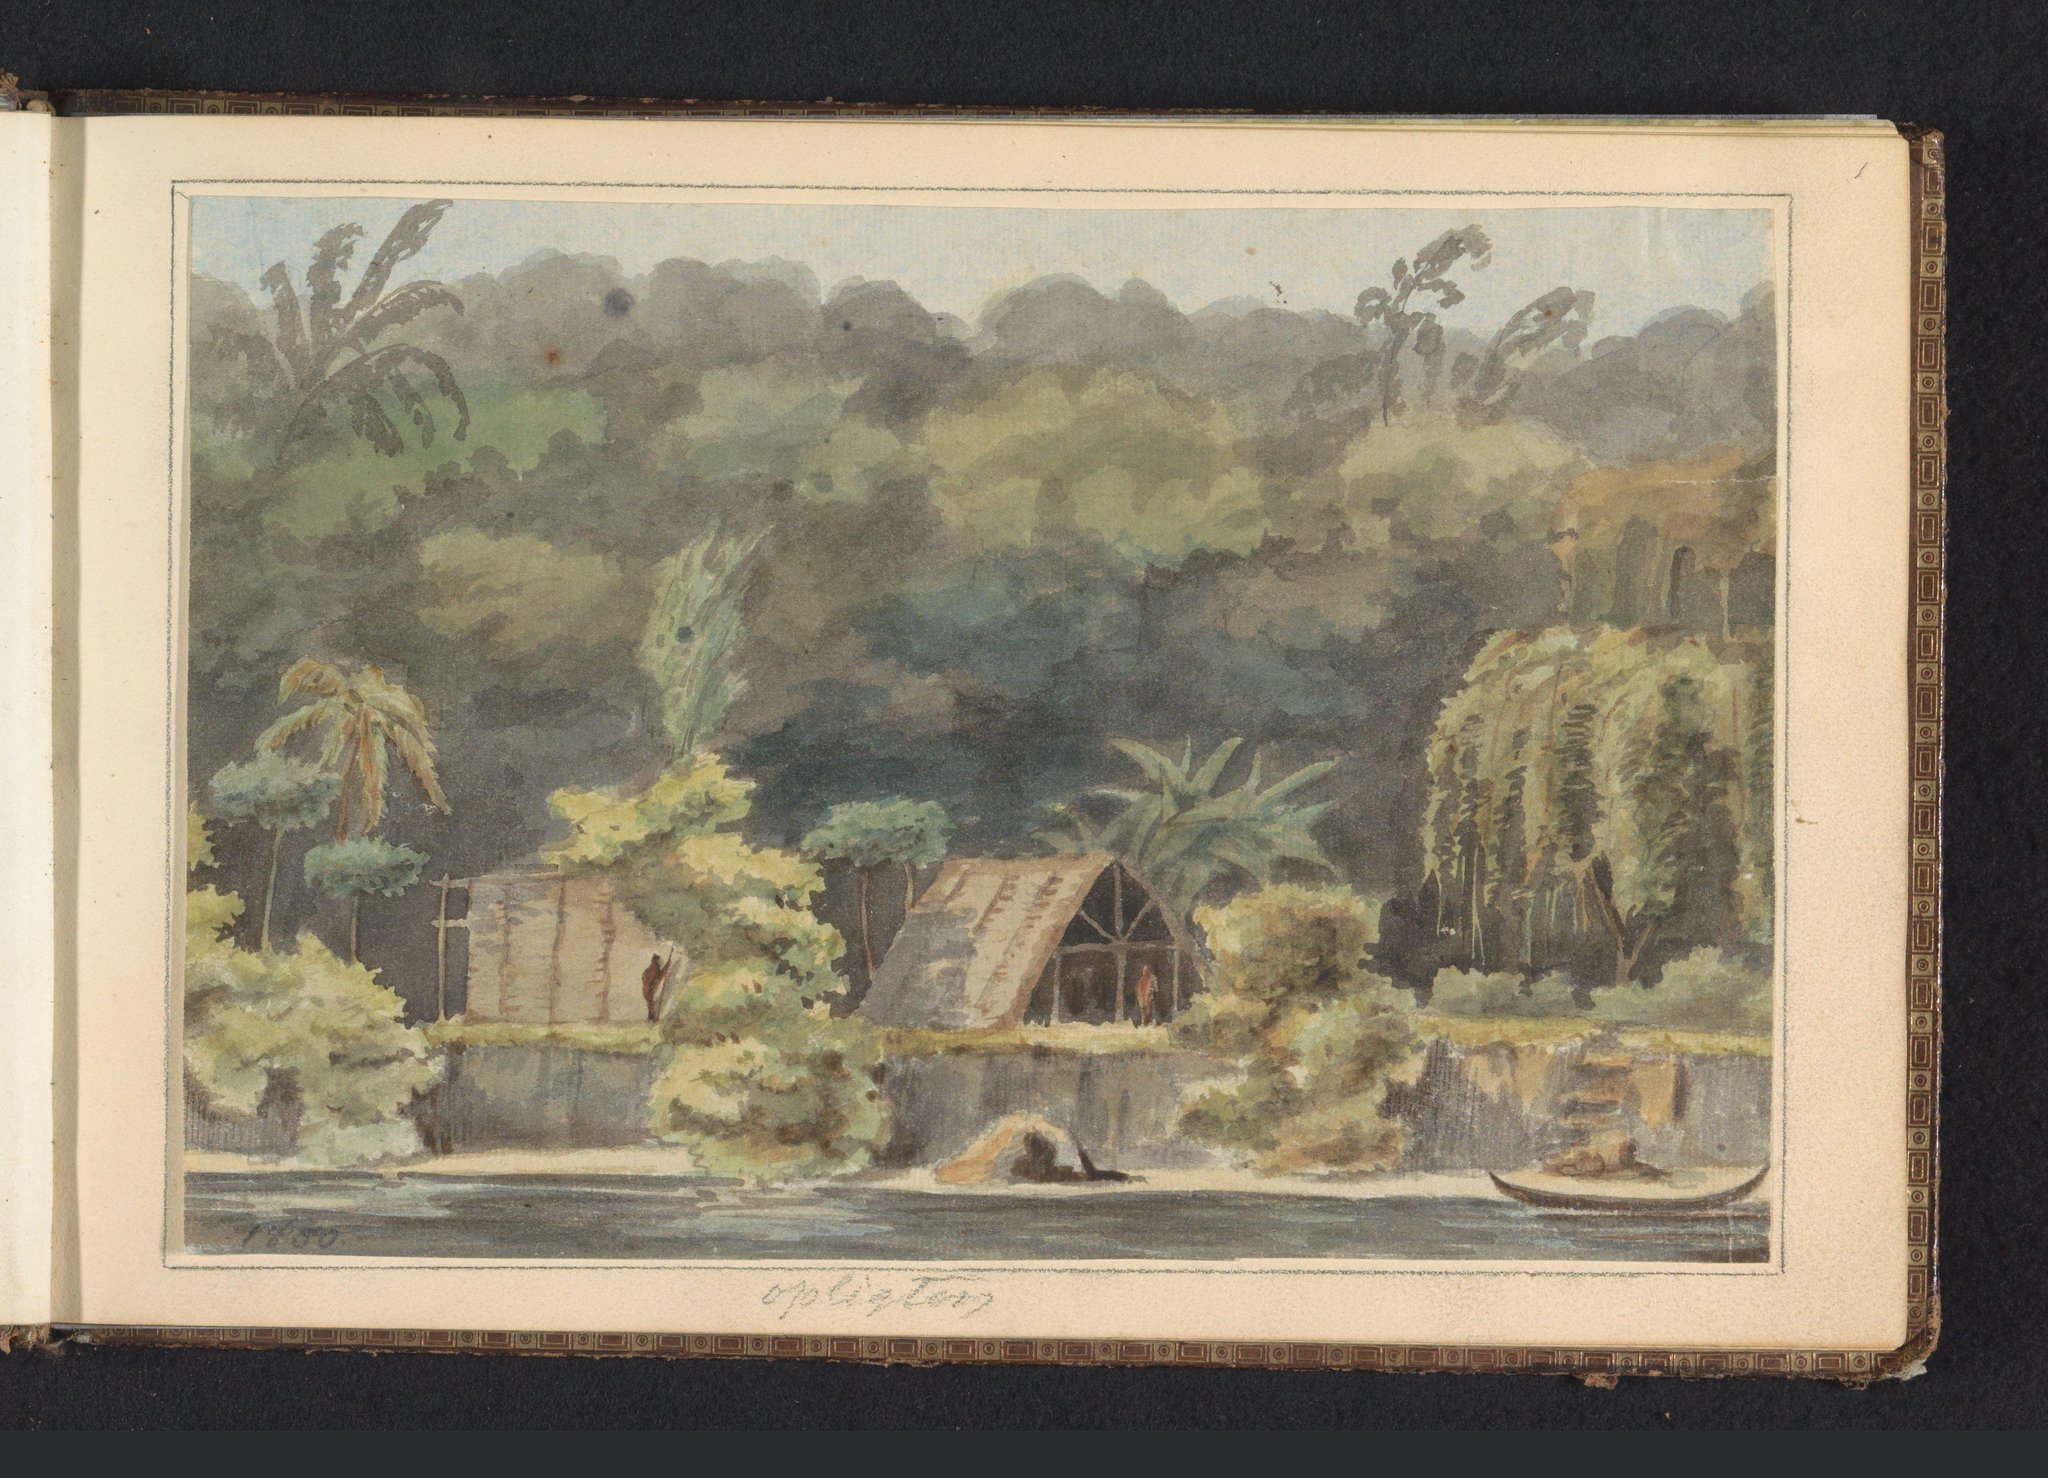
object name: album leaf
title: Oeman kondre aan de Marowijne rivier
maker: jacob marius adriaan martini van geffen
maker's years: 1821-1866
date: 1850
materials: ink, paper, pencil, watercolor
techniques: brush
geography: suriname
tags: suriname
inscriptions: date: ‘1850’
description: Gezicht op enkele woningen in het bos gezien vanaf de rivier.